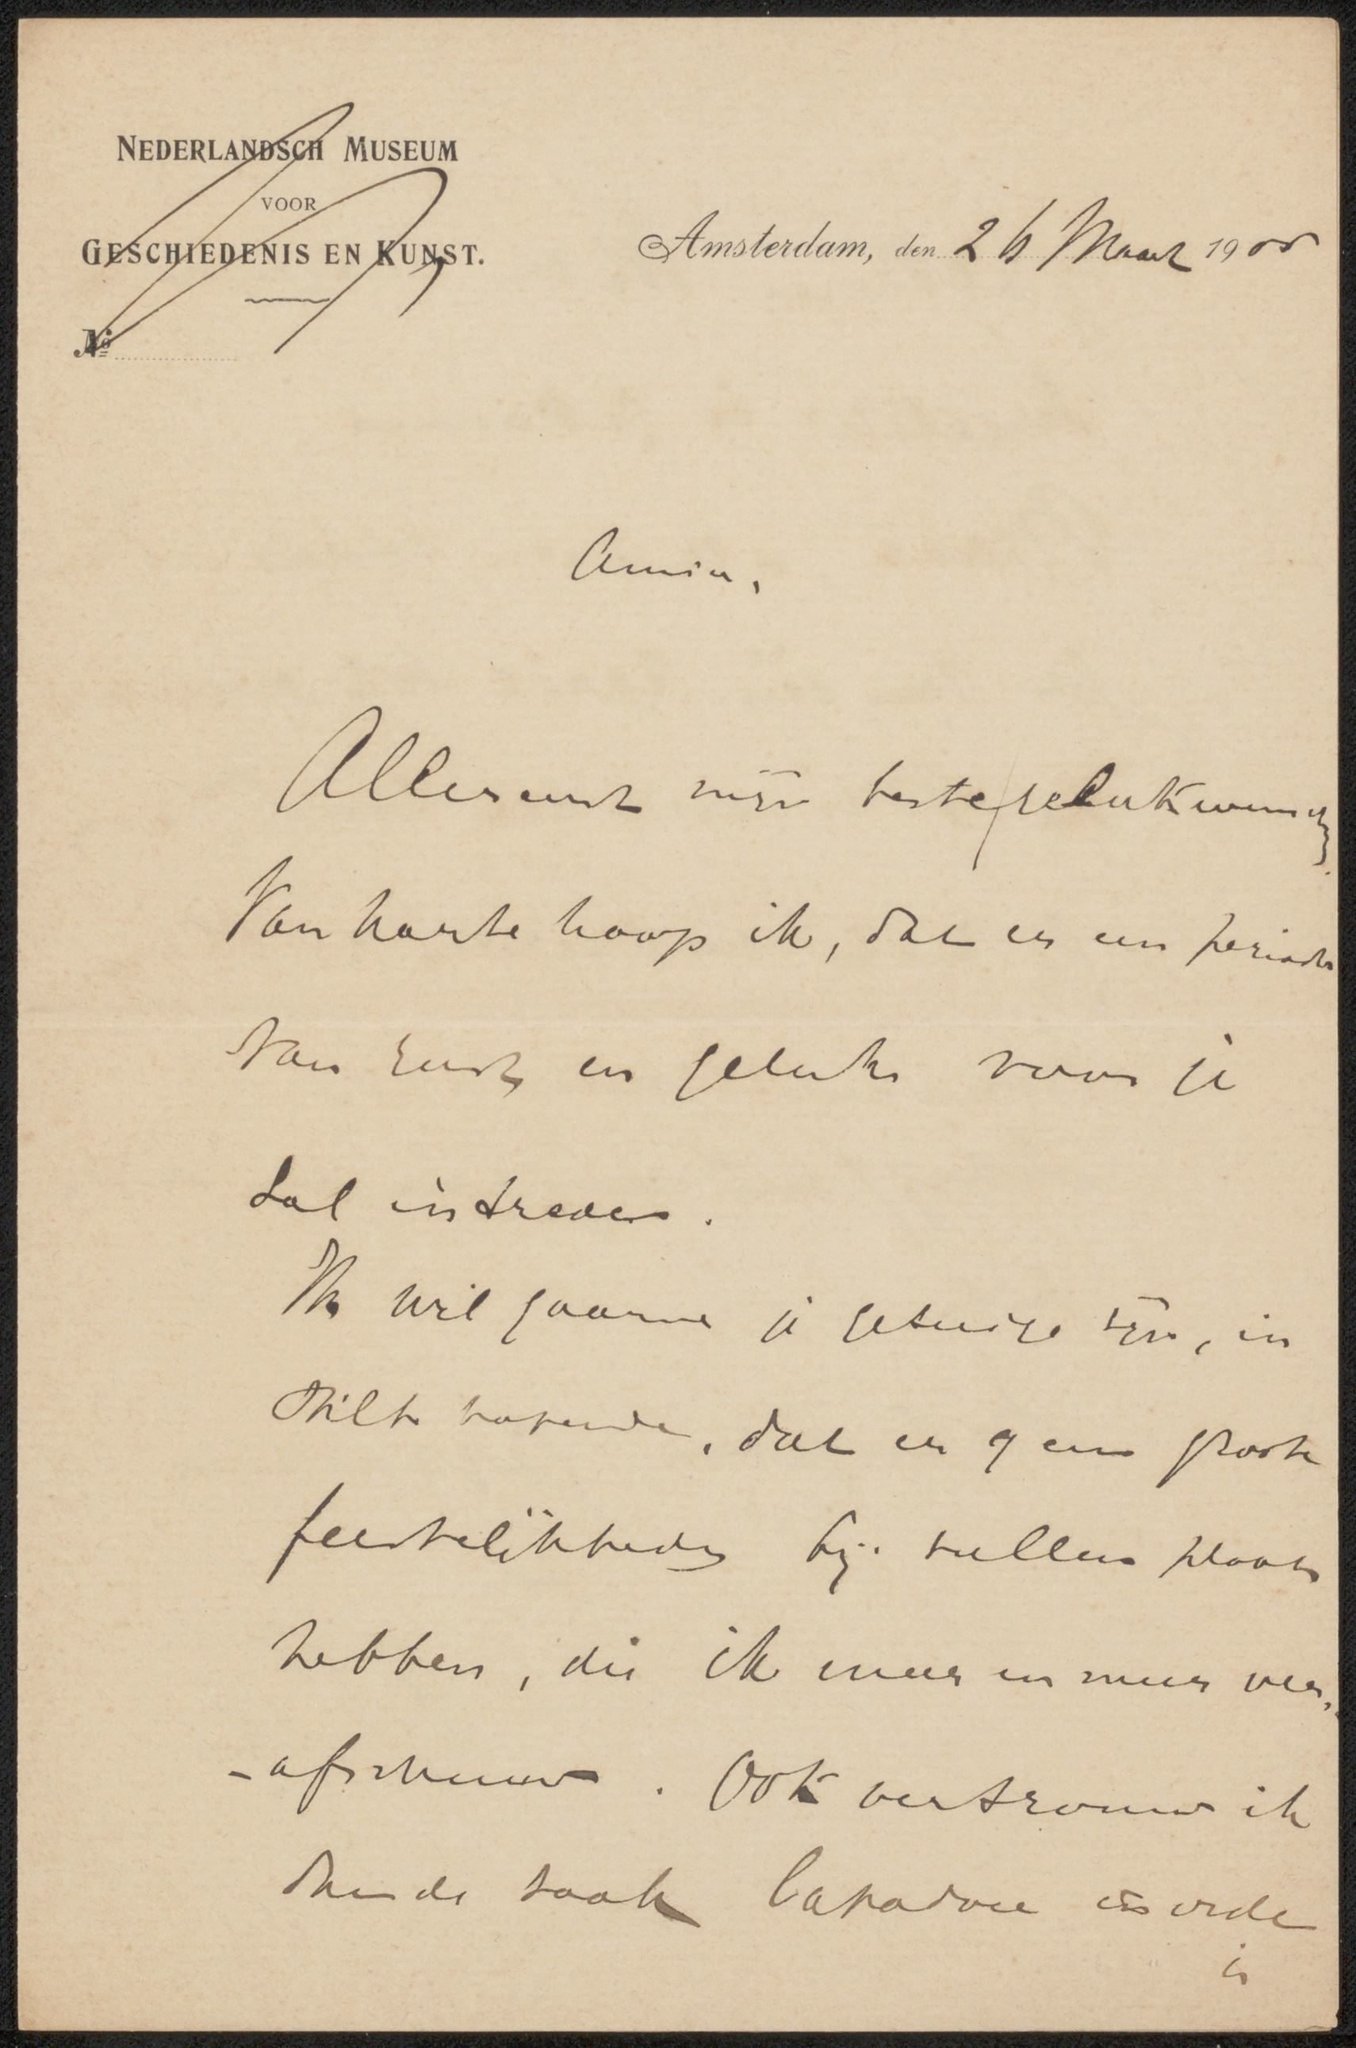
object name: letter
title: Brief aan Philip Zilcken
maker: adriaan pit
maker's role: print maker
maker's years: 1860-1944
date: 1906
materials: ink, paper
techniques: pen, printing, writing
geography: amsterdam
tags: painter, draughtsman, philip zilcken, family life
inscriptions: collector's mark: ‘RPK’